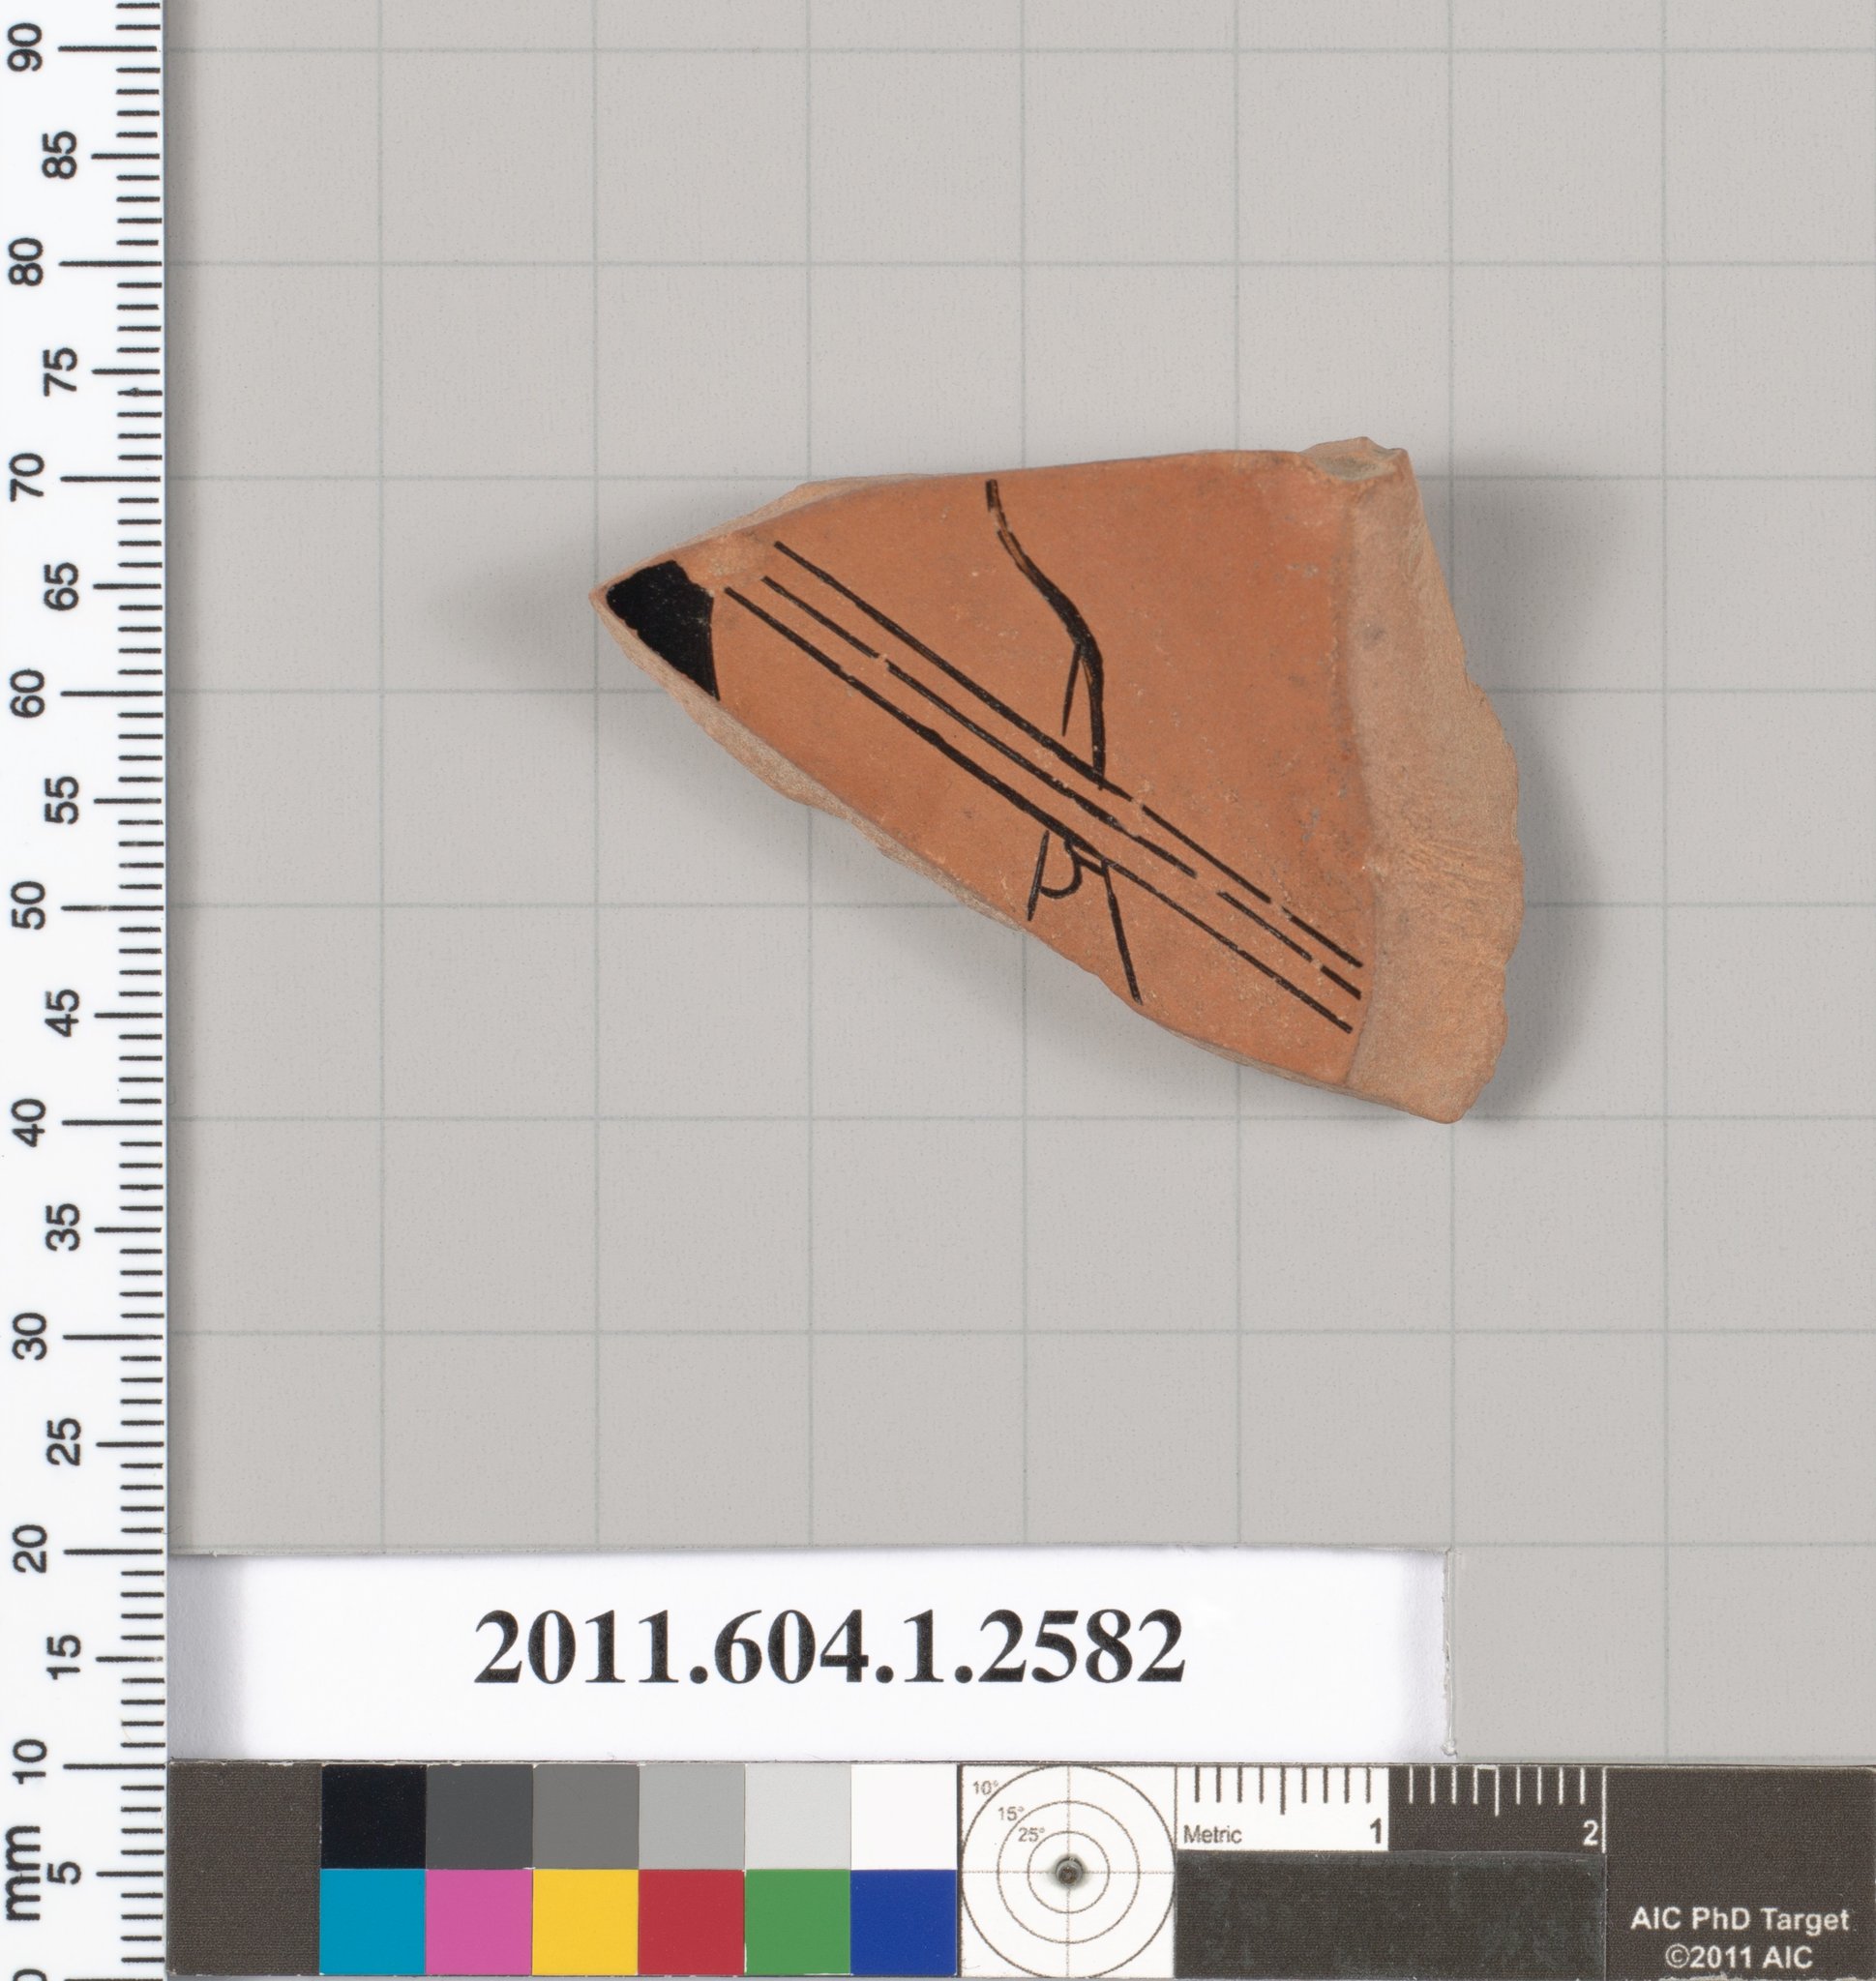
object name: kylix fragment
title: Terracotta fragment of a kylix (drinking cup)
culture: greek, attic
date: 490-480 BCE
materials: terracotta